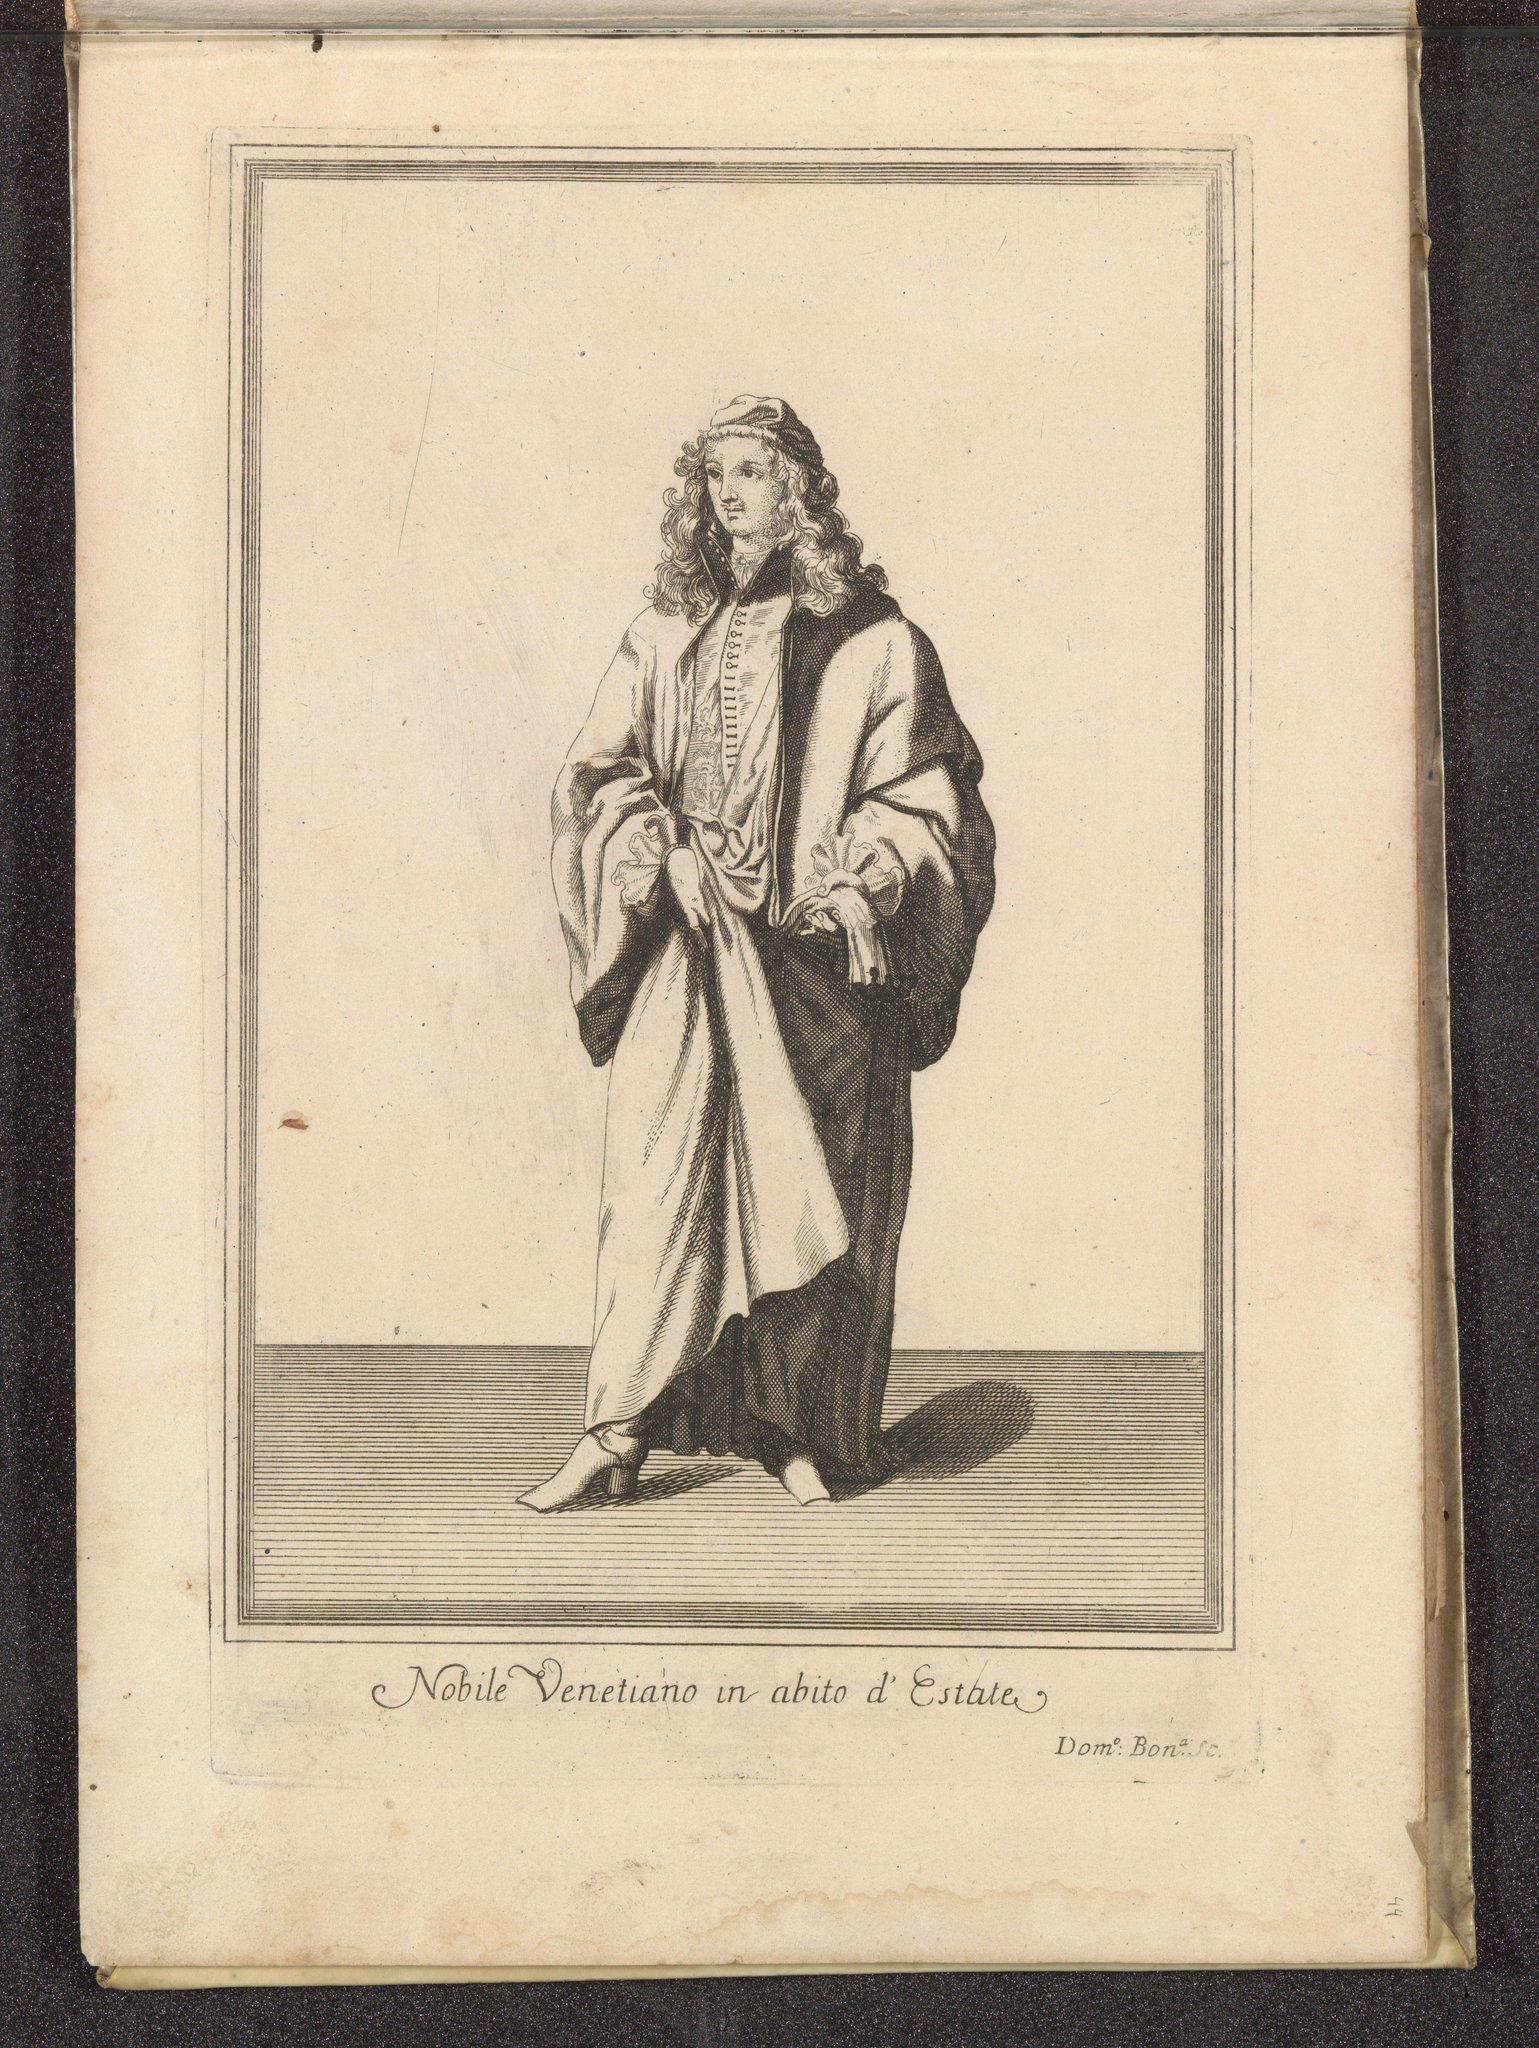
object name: album leaf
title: Nobile Venetiano in abito d'Estate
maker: domenico bonavera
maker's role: print maker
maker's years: 1640-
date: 1650-1740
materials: paper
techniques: engraving, etching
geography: italy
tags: standing figure, folk costume, regional costume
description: Titel in ondermarge. De prent maakt deel uit van een album.